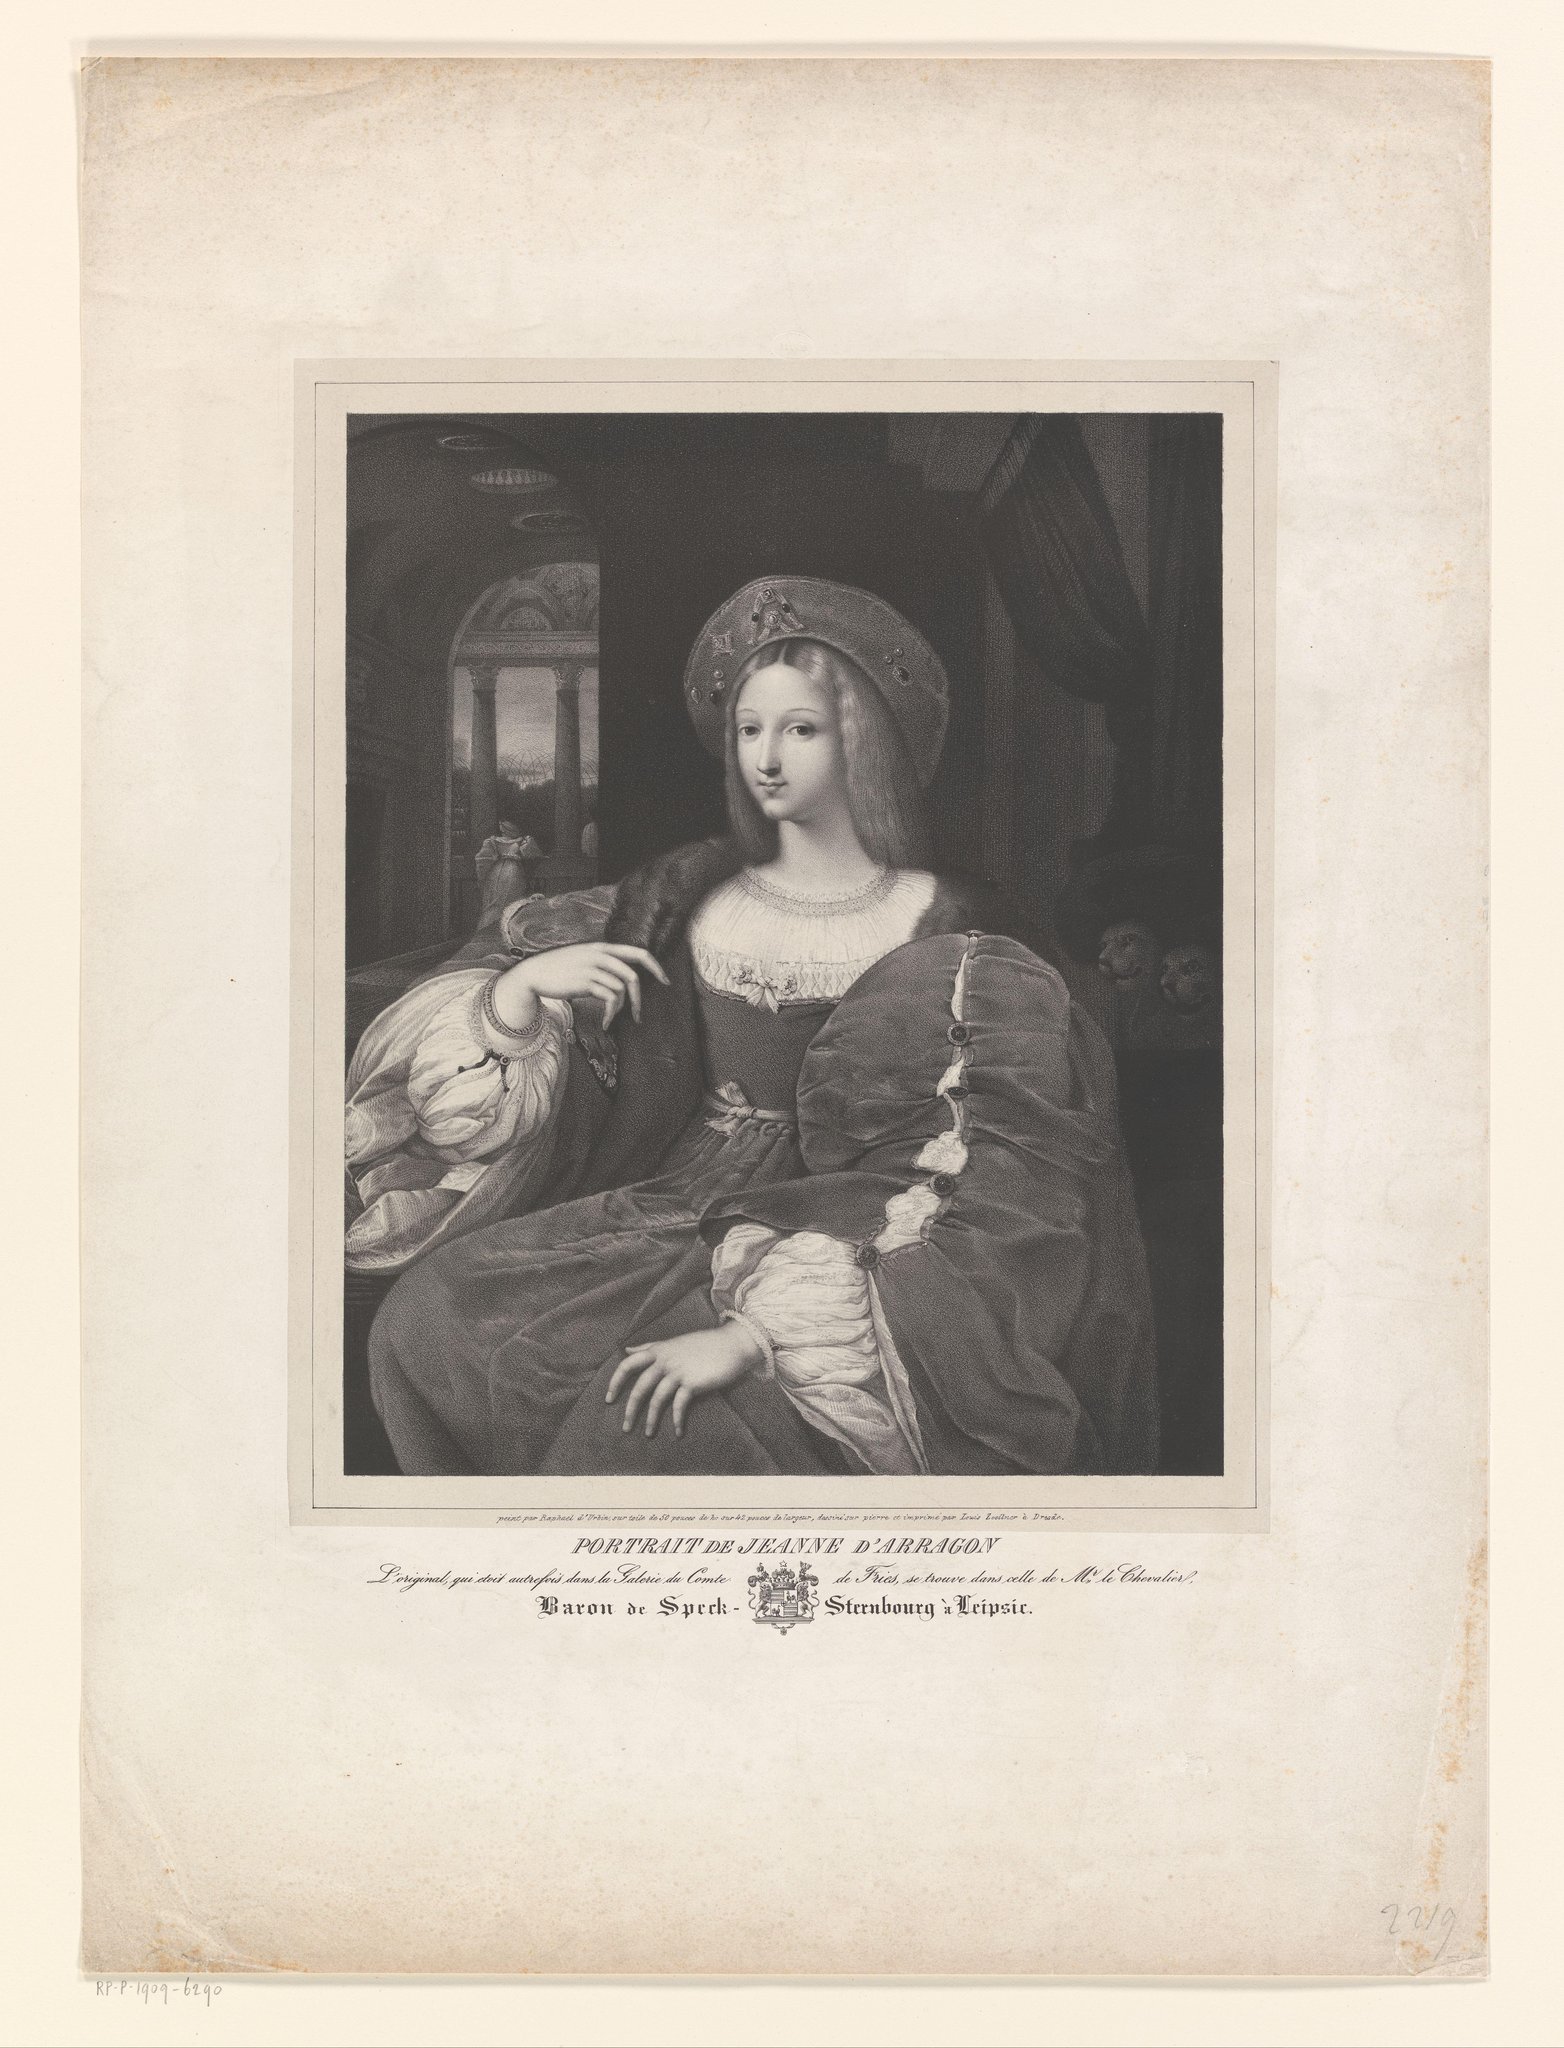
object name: print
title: Portret van Dona Isabel de Requesens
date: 1806-1860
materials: paper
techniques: lithograph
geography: dresden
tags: palace - aa - civic architecture: inside, adult woman, historical persons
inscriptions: collector's mark: Lugt 2228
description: Het portret werd eerder geïdentificeerd als Jeanne d'Arragon.